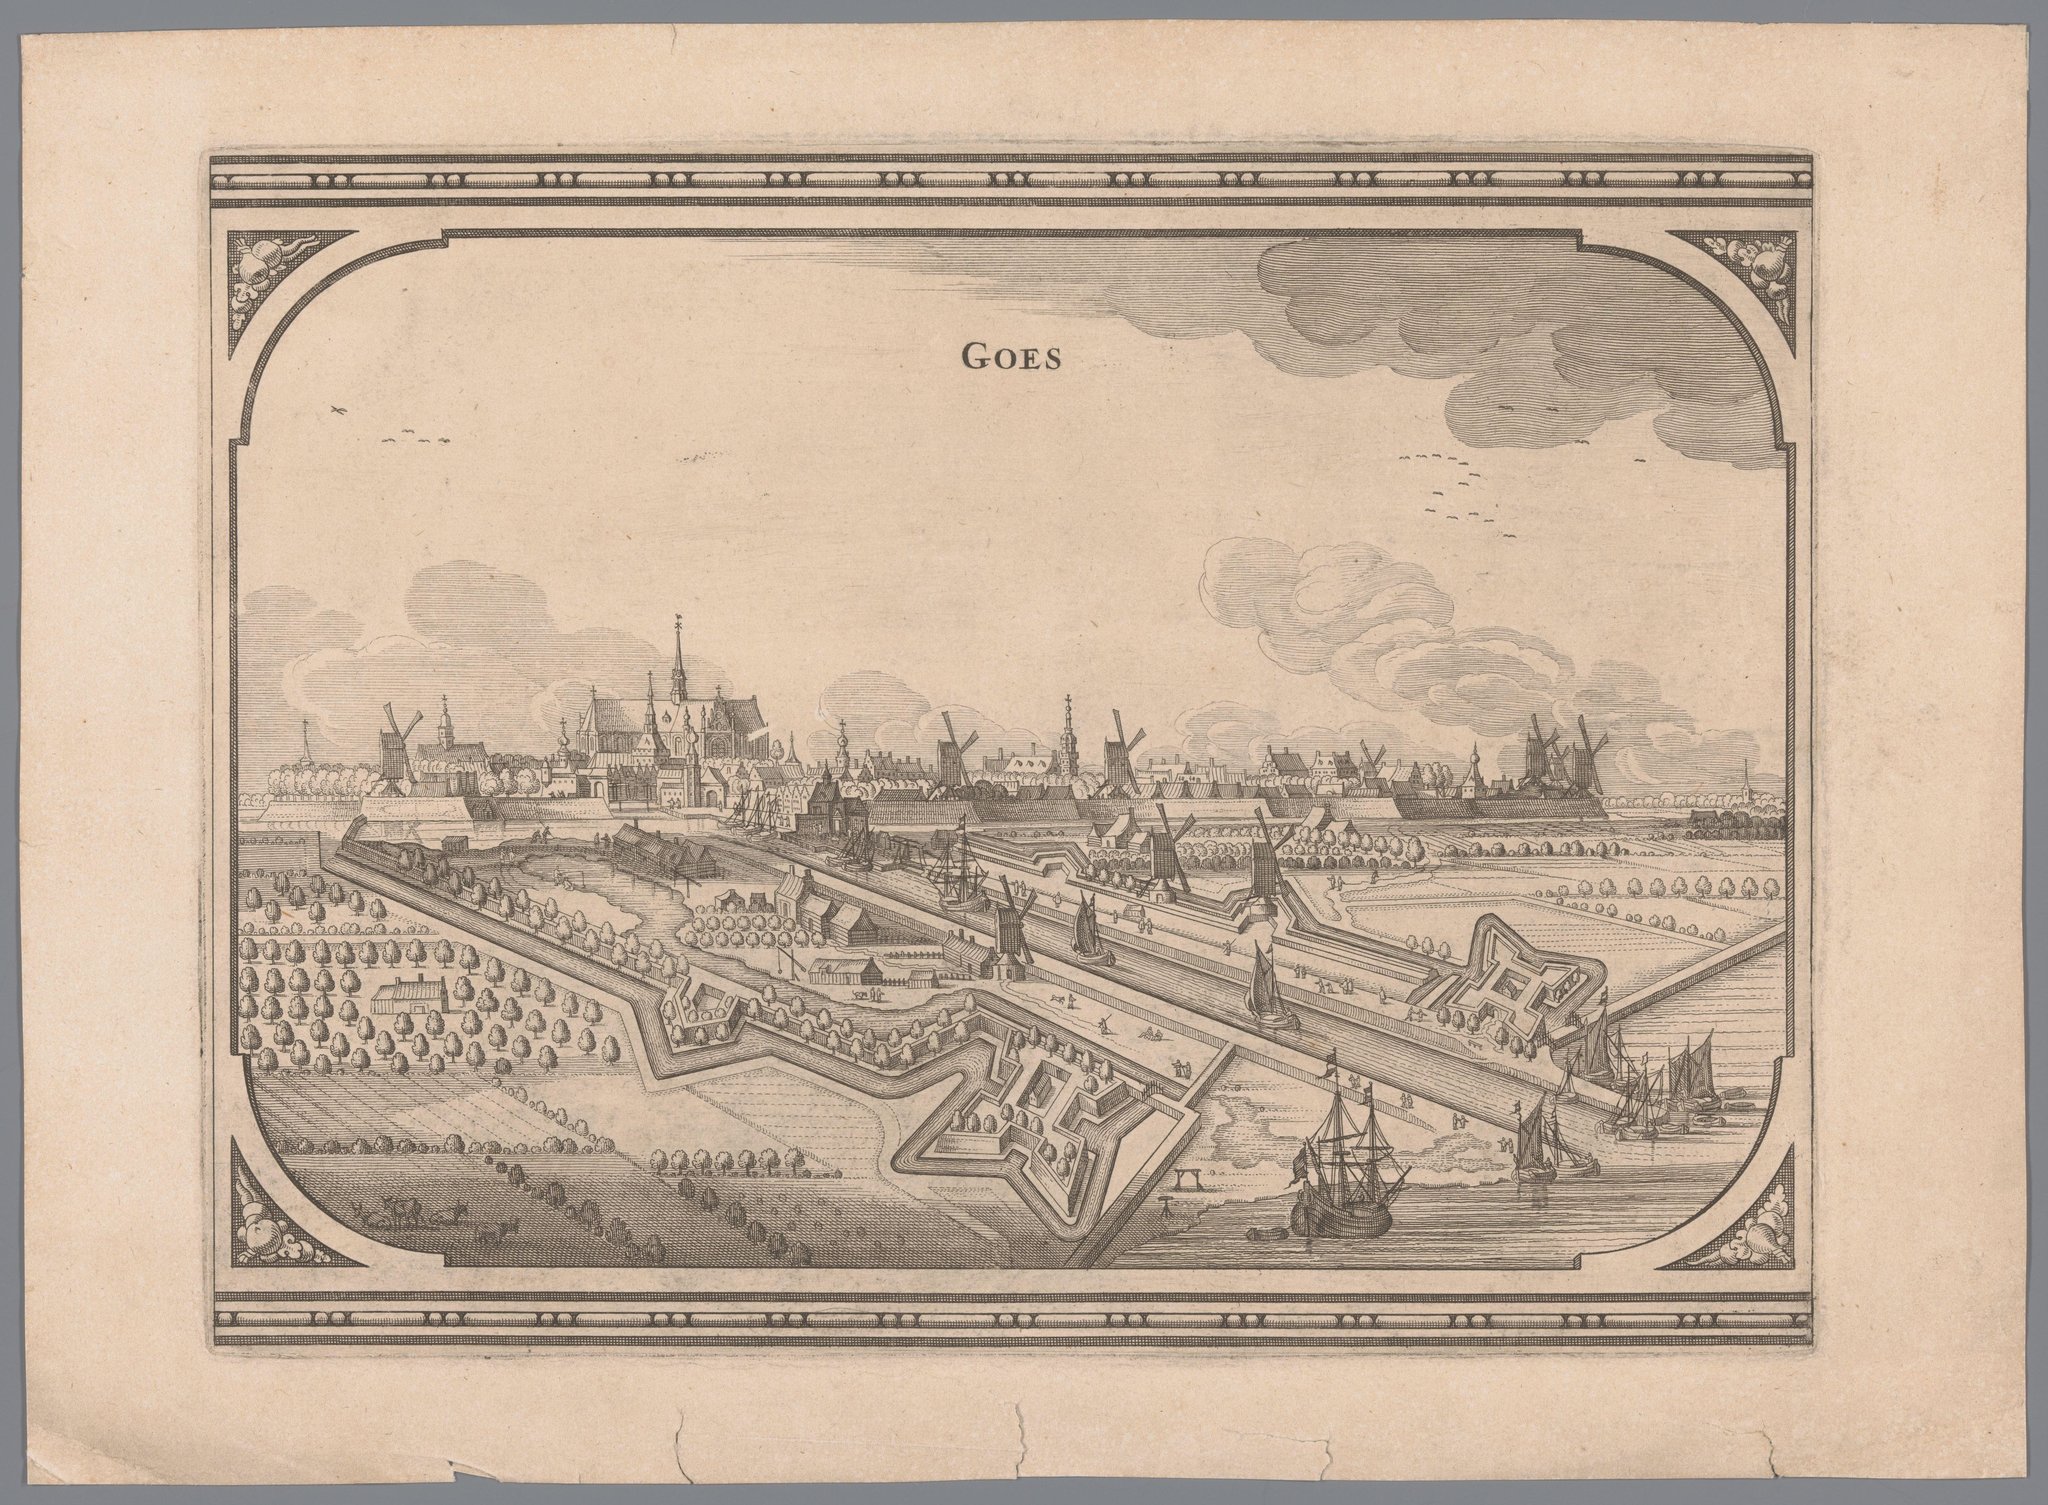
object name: print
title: Goes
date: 1656-1662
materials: paper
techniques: etching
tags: prospect of village, silhouette of village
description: Prent mogelijk verschenen in: Theatrum praecipuarum urbium ducatus Brababtiae necnon comitatum Flandriae et Zelandiae. Amsterdam: Nicolaes Visscher, 1657. Of in: Schut, Pieter Hendricksz.Theatrum praecipuarum urbium ducatus Brababtiae necnon comitatum Flandriae et Zelandiae. Amsterdam: Nicolaes Visscher, 1657. En in: Caerten en Steden van Brabant, Vlaenderen ende Zeelandt, Middelburg. Middelburg: Zacharias Roman; Amsterdam: Nicolaes Visscher, 1656. Verschillende staten van prenten zijn gebruikt in andere uitgaven van 'Speculum Zelandiae' en in andere publicaties uitgegeven door Zacharias Roman en Nicolaes Visscher (I). Verwarring rondom de datering kan ontstaan door het feit dat de prenten uit 'Speculum Zelandiae' ook voorkomen in eerder uitgegeven publicaties, waar ze later in zijn ingebonden. Zo komen prenten uitgegeven door Roman/Visscher voor in sommige exemplaren van: Boxhorn, Marcus Zuerius van. Chroniick van Zeelandt (…). 2 dln. Middelburg: Zacharias Roman, 1644. De door weduwe (Joachim) Ottens en Zoonen uitgegeven prenten zijn later ingebonden in sommige exemplaren van: Smallegange, Mattheus. Nieuwe Cronyk van Zeeland (…). Middelburg en Amsterdam: Johannes Meertens en Abraham van Someren, 1696.